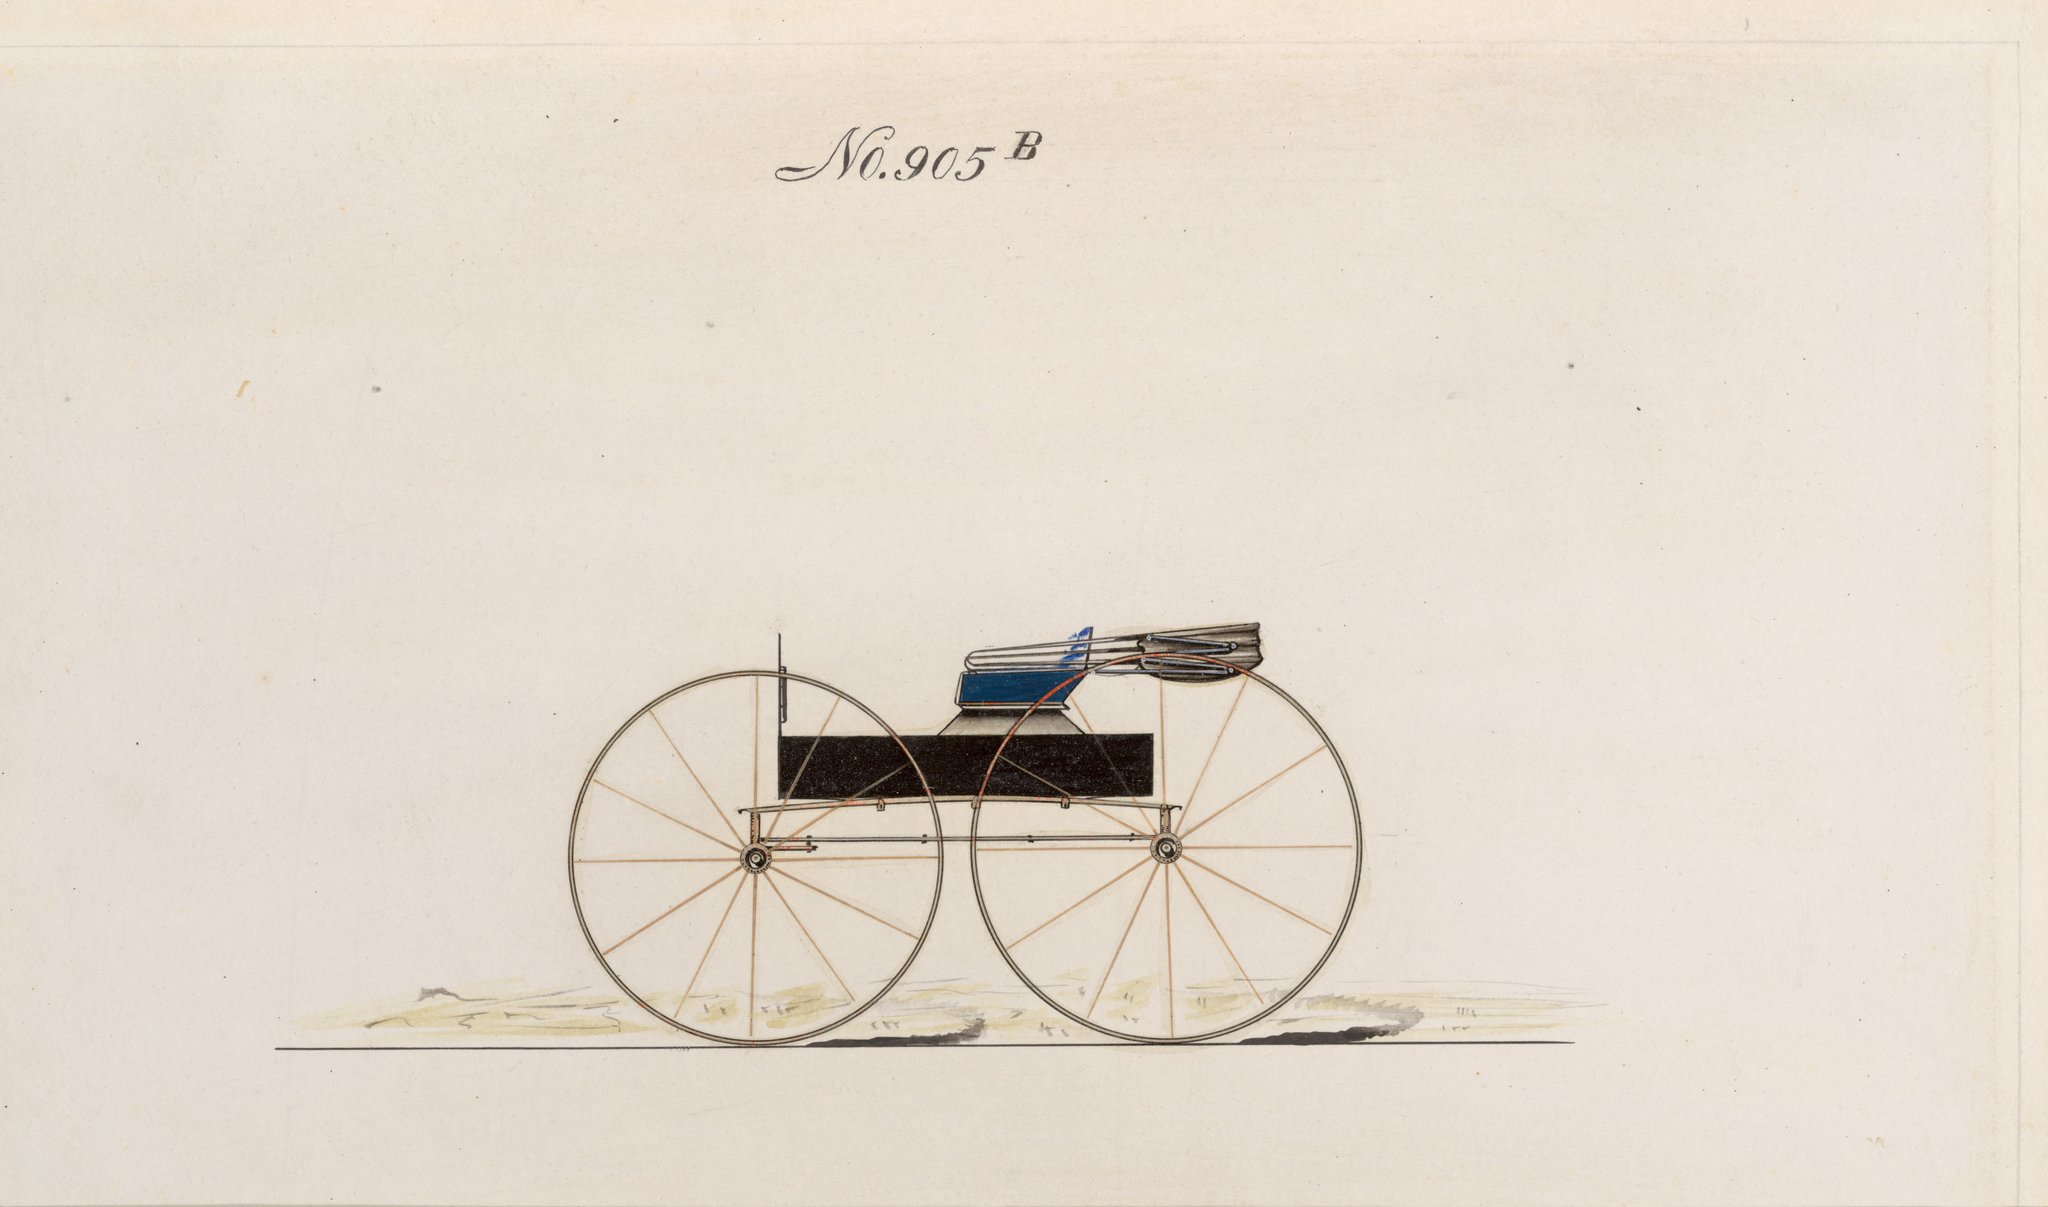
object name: album drawing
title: Album of 29 presentation drawings of various types of carriages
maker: brewster & co.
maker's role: artist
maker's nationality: american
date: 1870-1878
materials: gouache, gum arabic, ink, watercolor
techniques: pen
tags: carriages